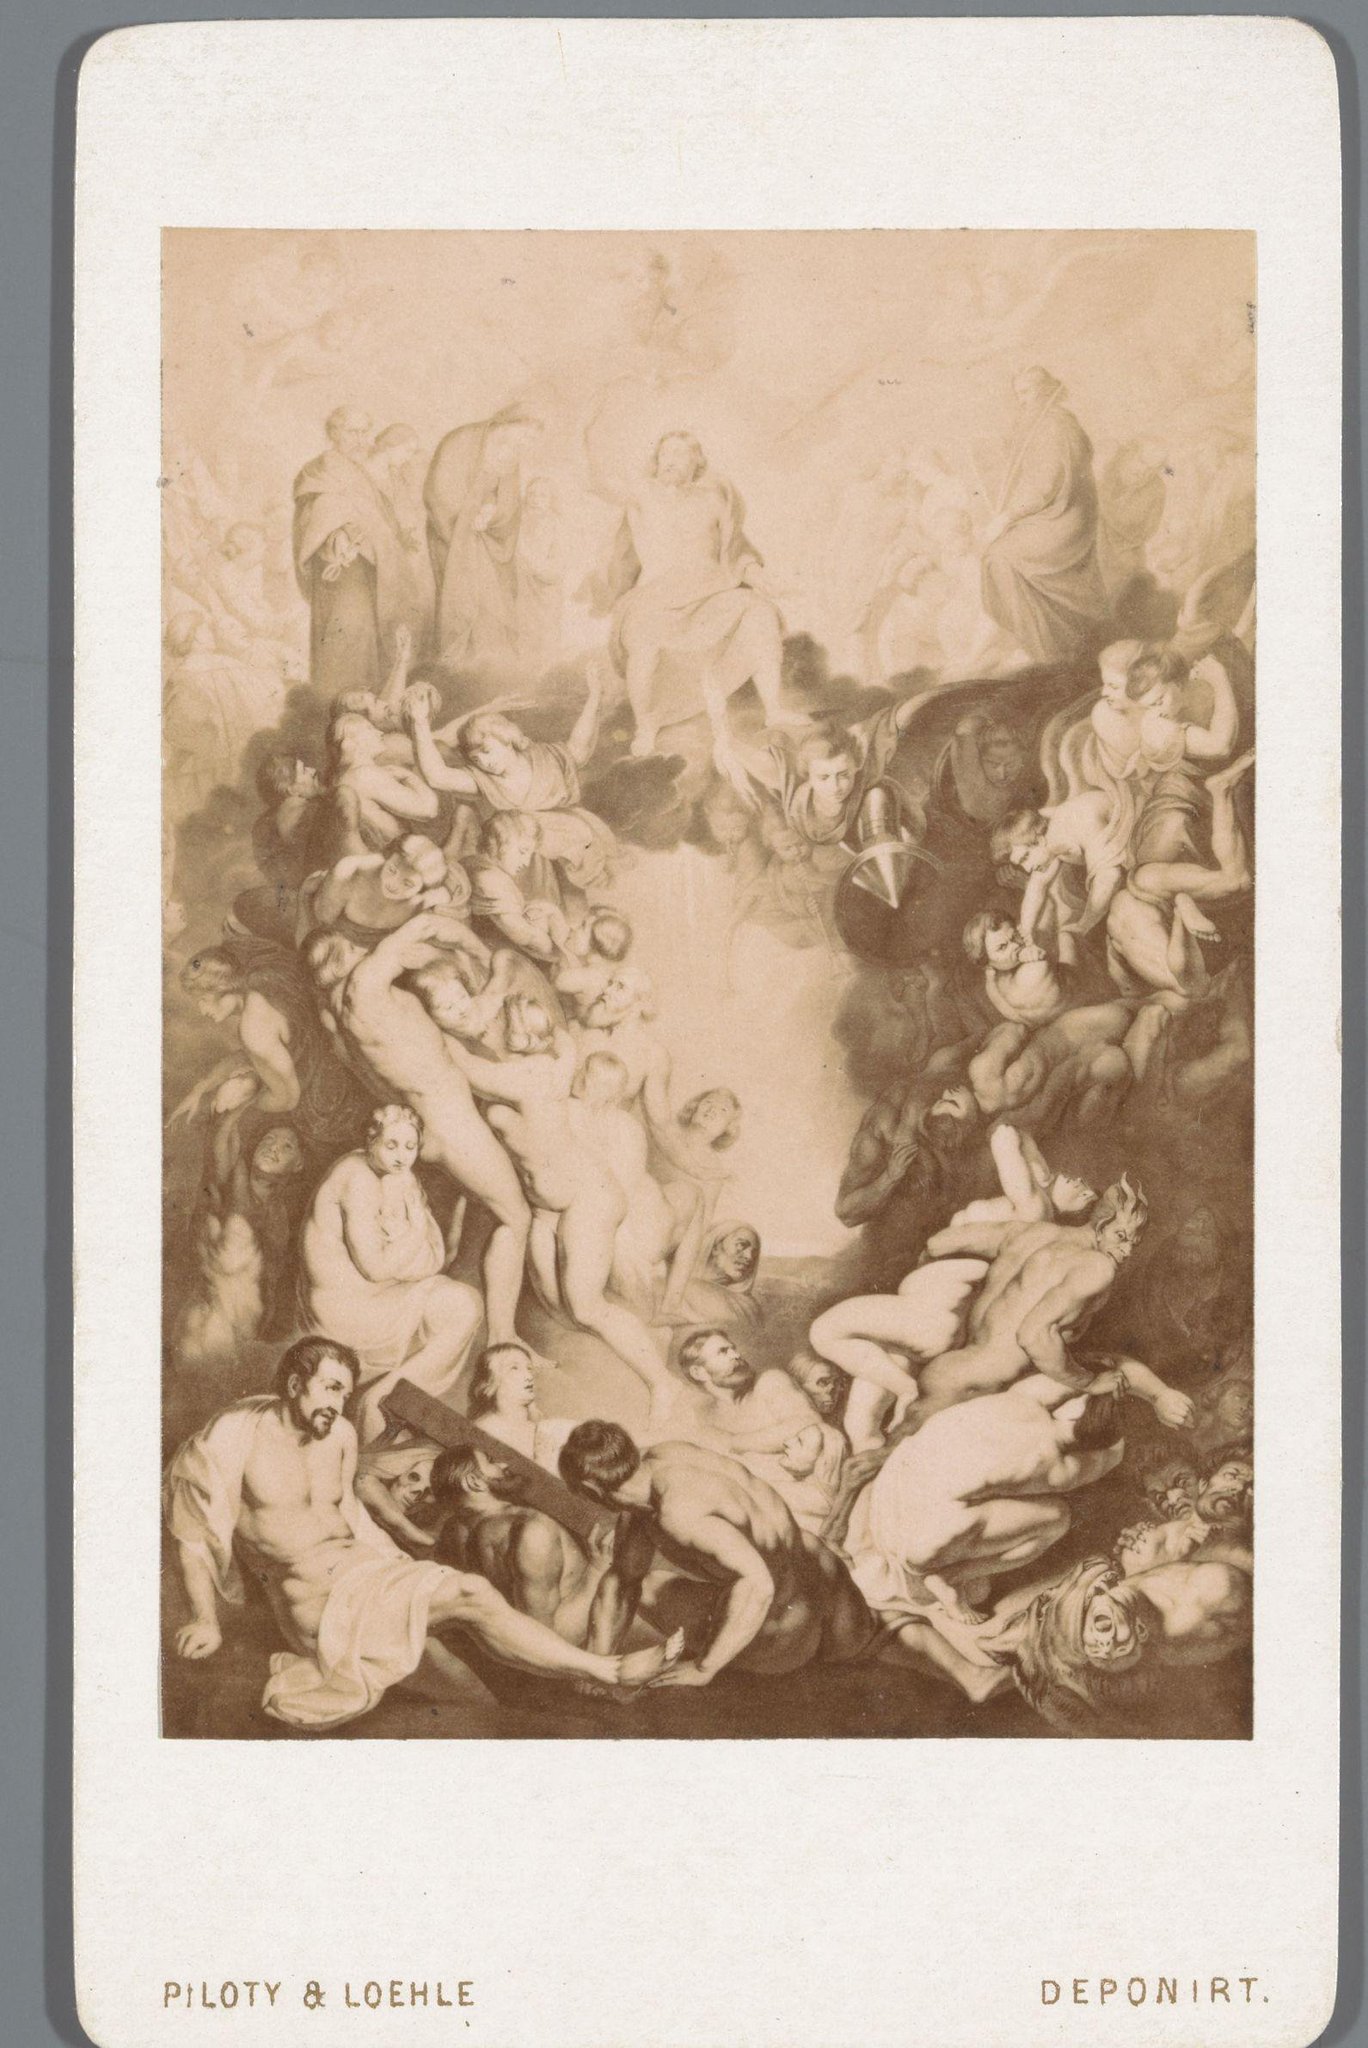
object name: carte de visite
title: Fotoreproductie van Das jüngste Gericht door Peter Paul Rubens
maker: Anonymous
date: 1855-1885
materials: cardboard, paper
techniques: albumen print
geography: munich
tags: comprehensive representation of last judgement: christ (with sword and lily), often surrounded by elders and sometimes accompanied by mary and john the baptist, appears in the sky with trumpeting angels (and sometimes angels holding the instruments of the passion); after the resurrection of the dead the blessed are led to heaven by angels, and the damned are dragged into hell by devils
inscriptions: inscription: ‘K. B. PINAKOTHEK IN MÜNCHEN./ 124./ P. P. RUBENS./ (...)/ Vor Nachbildung geschützt.’